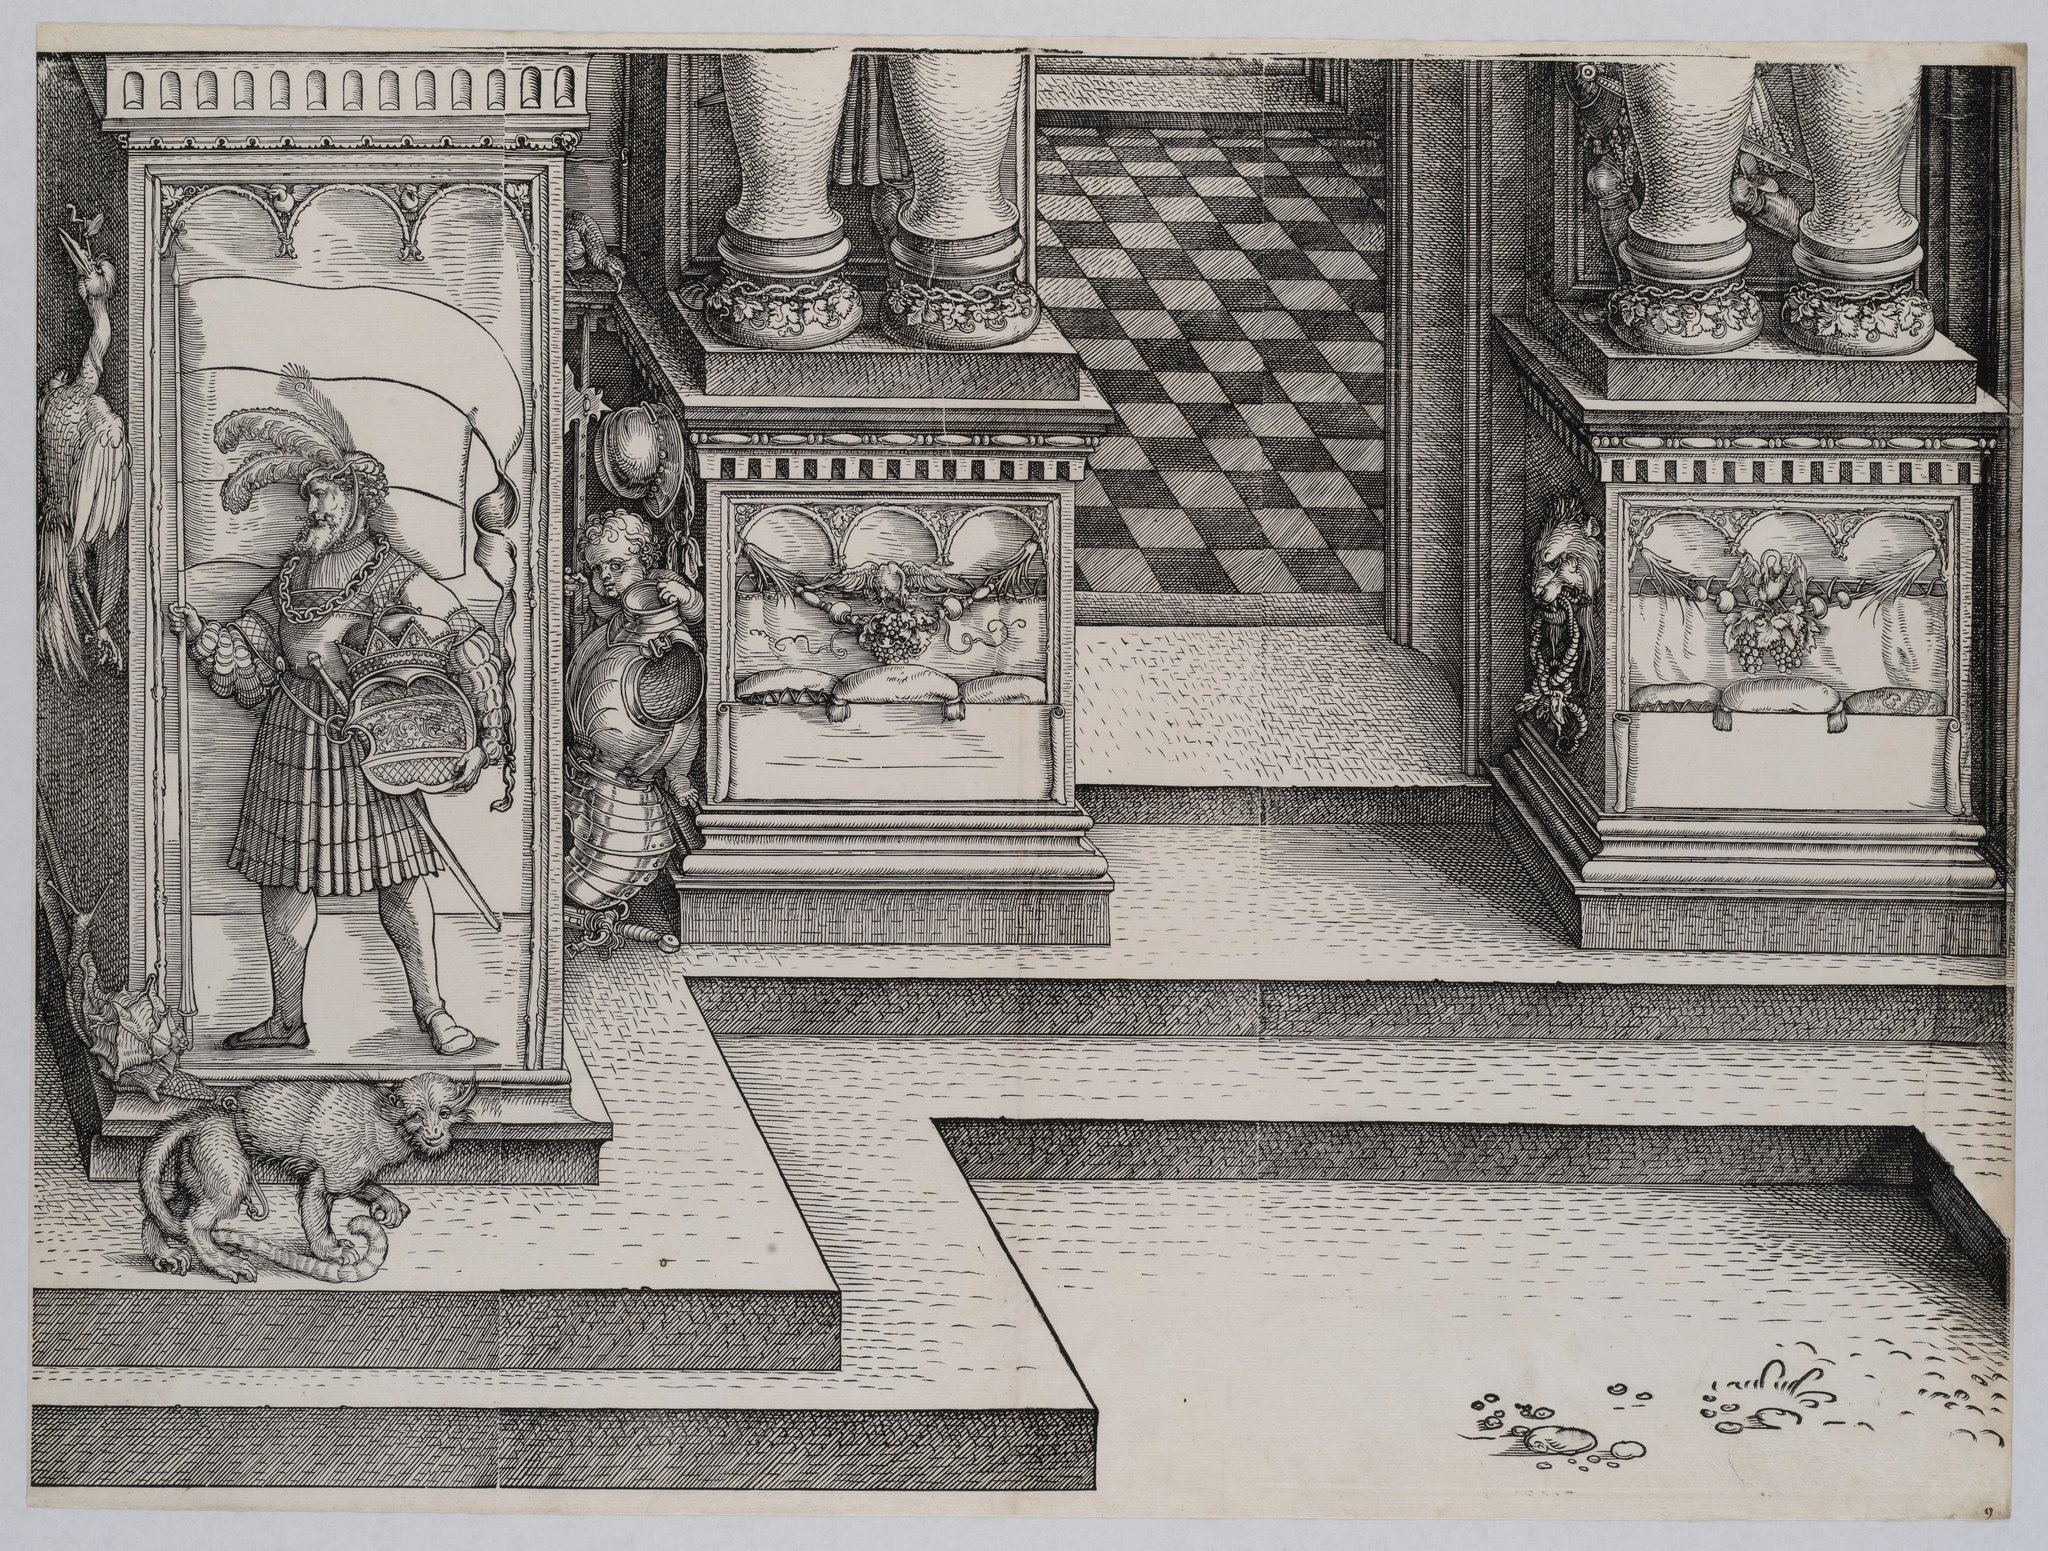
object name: print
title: Lower Portion of the Entryway to the Right Portal (Die Porten des Adels); and the Outer Right Sockel of the Central Portal, from the Arch of Honor, proof, dated 1515, printed 1517-18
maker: albrecht dürer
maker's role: artist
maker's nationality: german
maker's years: 1471-1528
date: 1515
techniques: woodcut